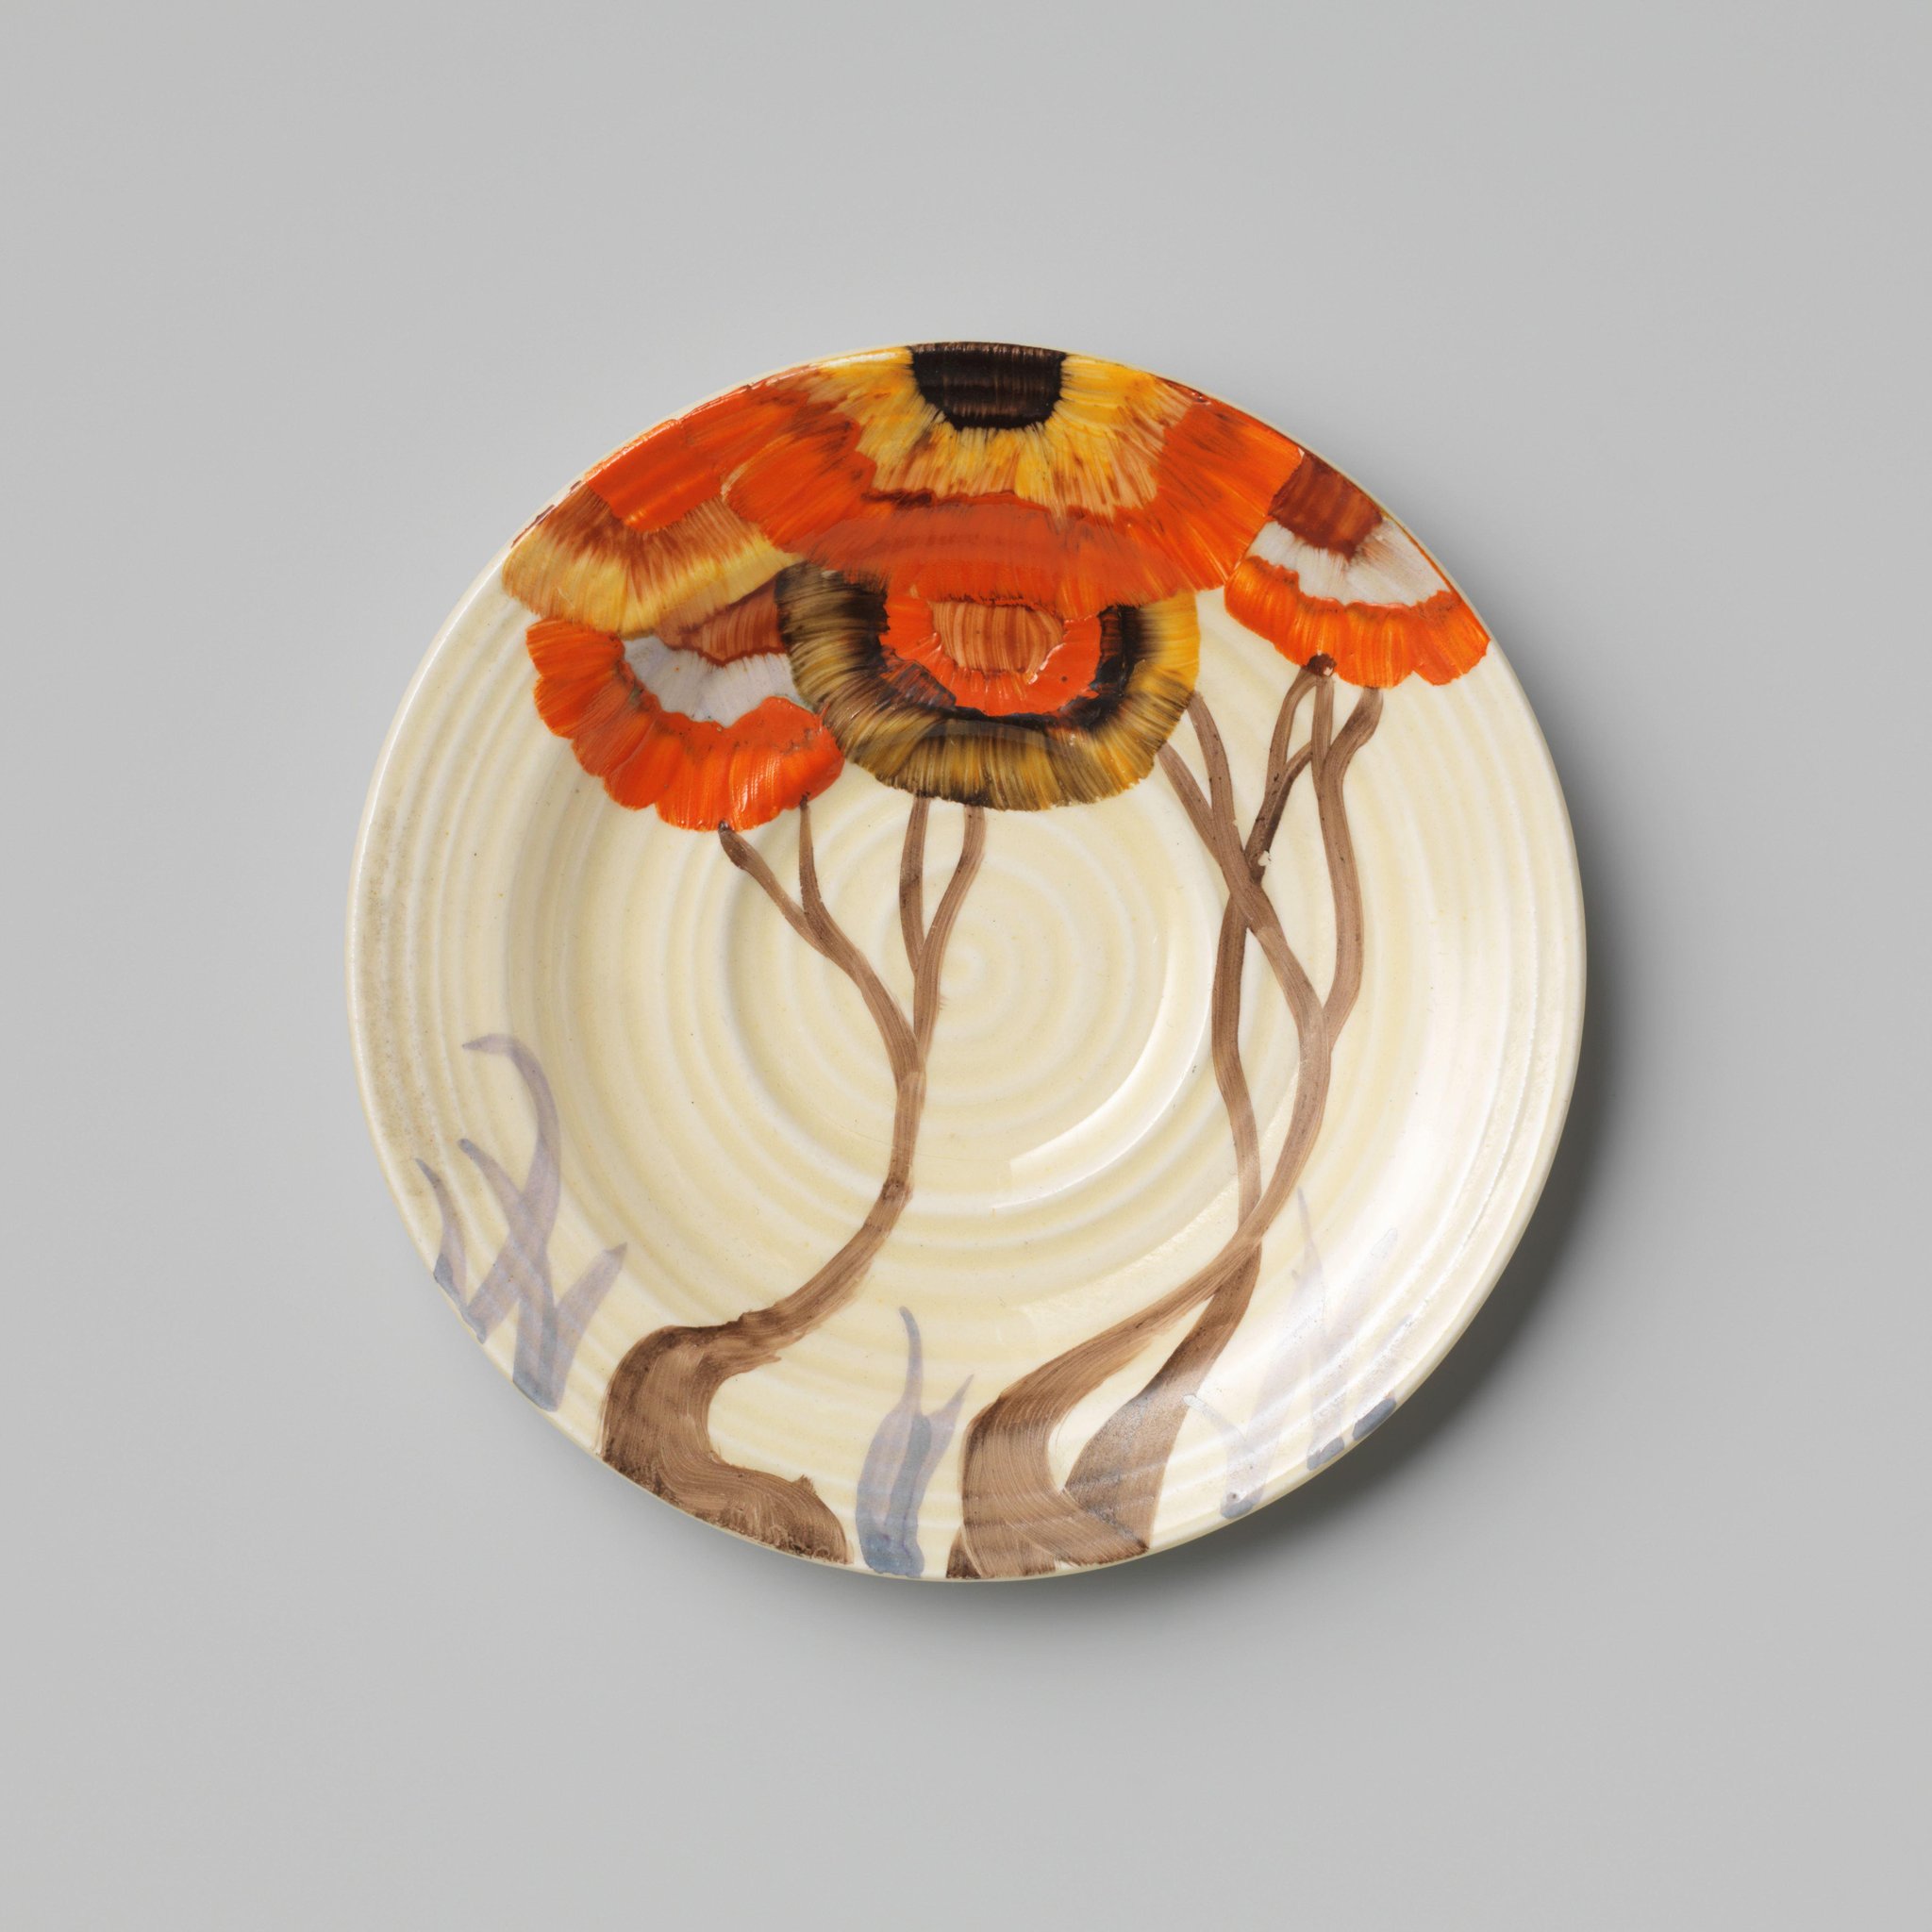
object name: platter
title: Schotel met veelkleurig bloemendecor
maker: clarice cliff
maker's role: ceramicist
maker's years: 1899-1972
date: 1930-1940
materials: earthenware, chemical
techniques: painted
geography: england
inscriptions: mark: ‘HAND PAINTED, BIZARRE by CLARICE CLIFF, WILKINSON Ltd, ENGLAND, gestempeld in zwart’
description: Schotel van aardewerk, veelkleurig beschilderd met bloemendecor. Onderdeel van theeservies.